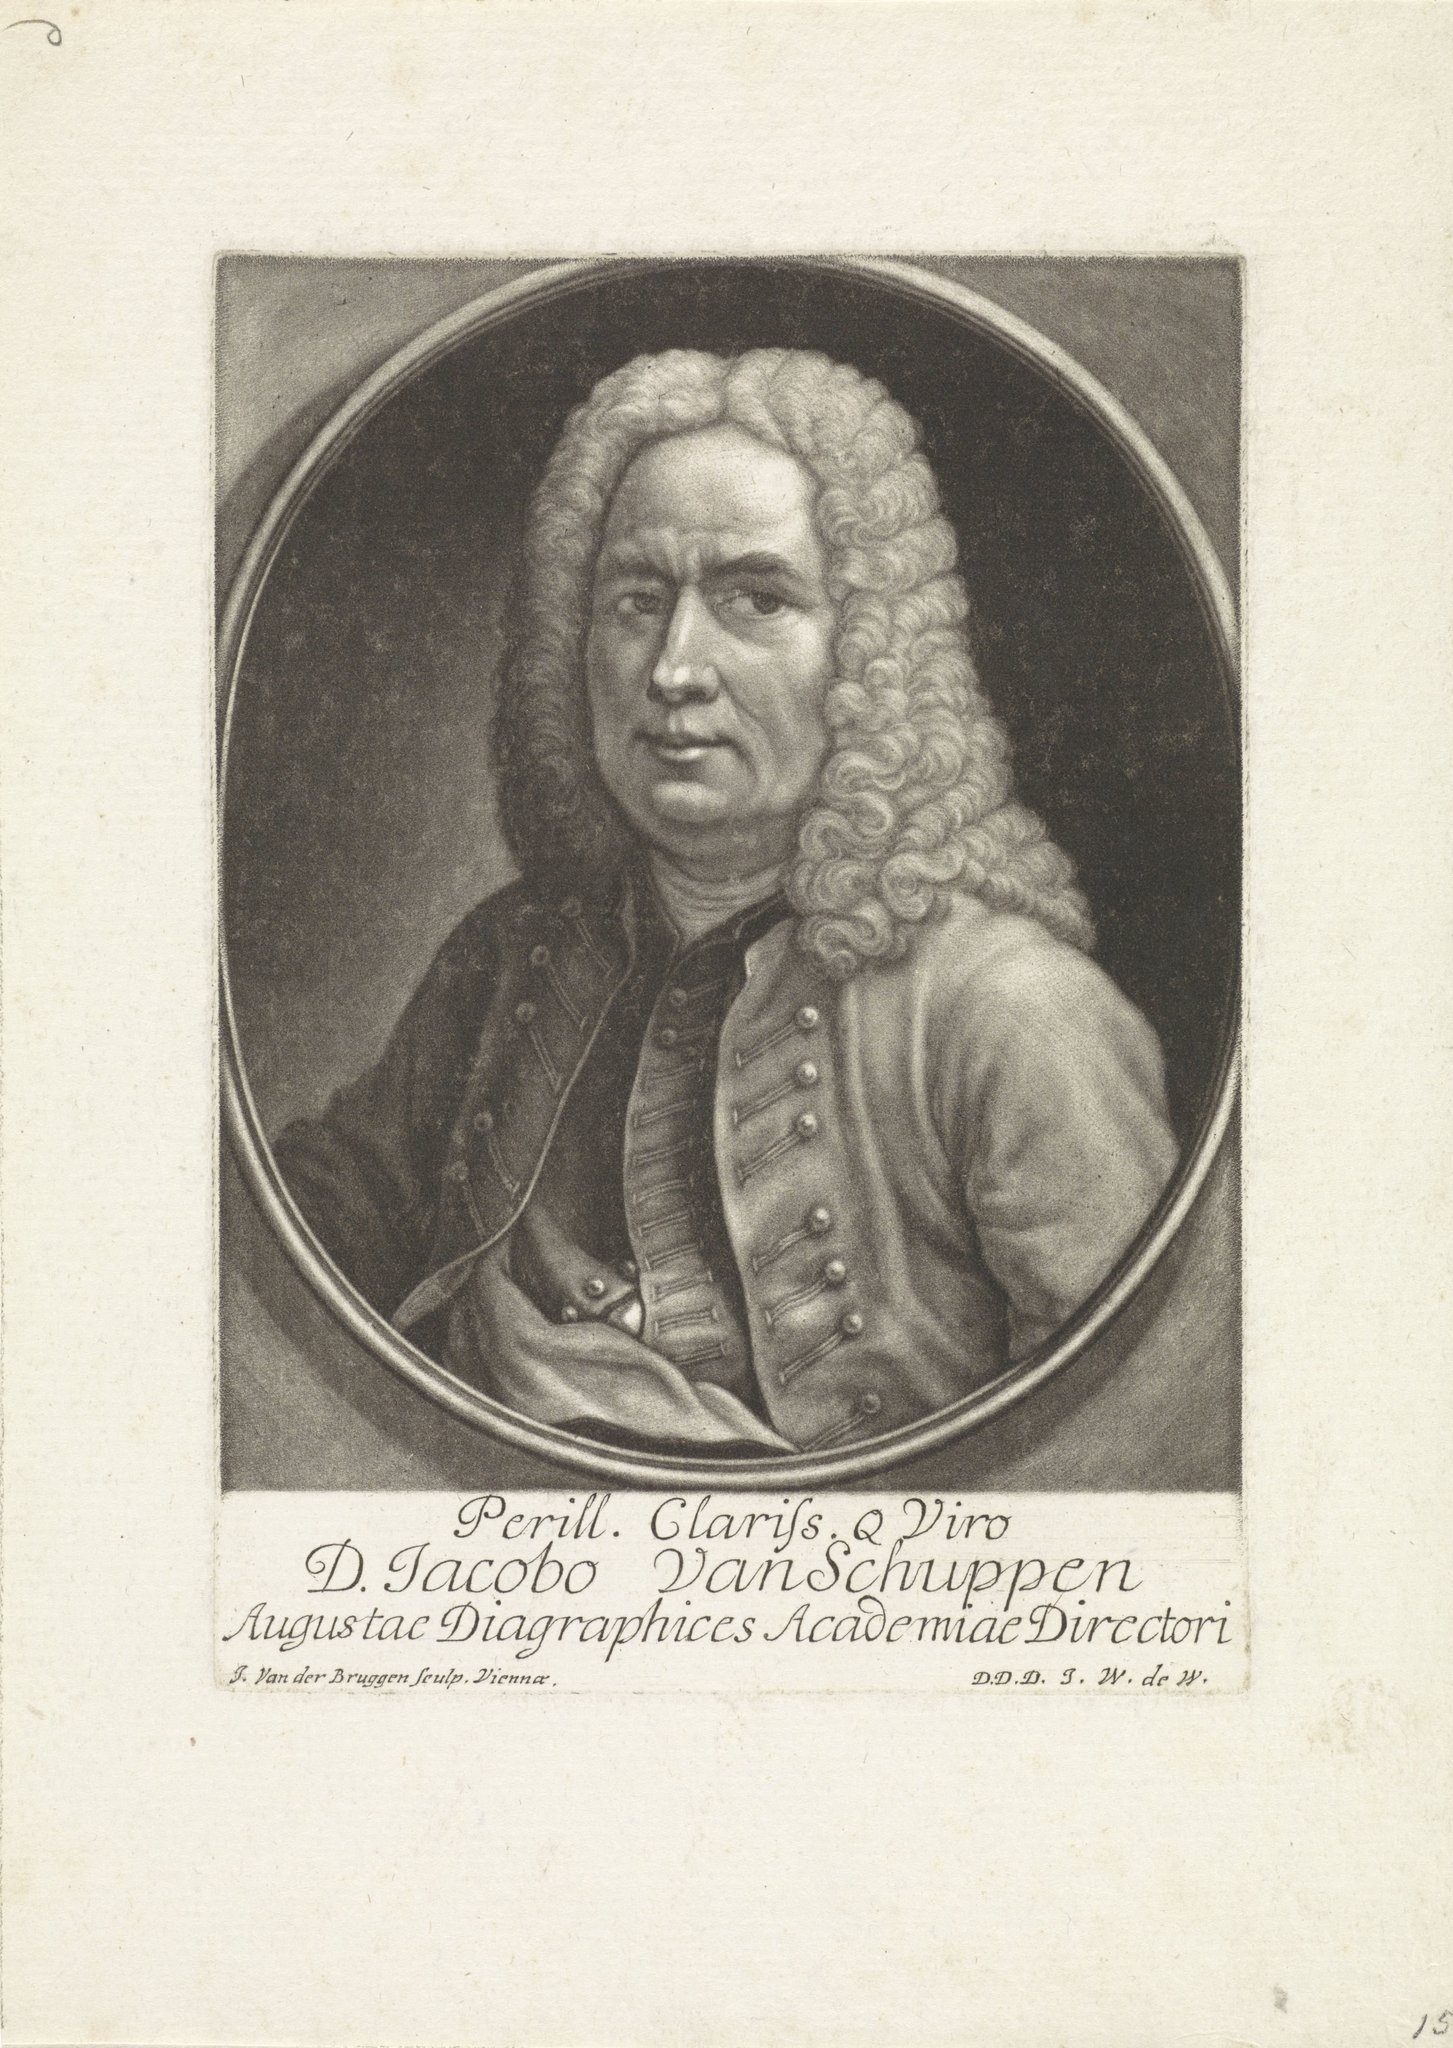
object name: print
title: Portret van Jacob van Schuppen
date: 1731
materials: paper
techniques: engraving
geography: vienna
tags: vienna, jacob van schuppen, wig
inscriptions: collector's mark: Lugt 2228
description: Ook gebruikt als illustratie in: Fresnoy, Charles Alphonse Du. Pictoriae artis Pandaesia: Die Kunst-Gründe der Zeichnung und Mahlerey, Wenen, 1731.